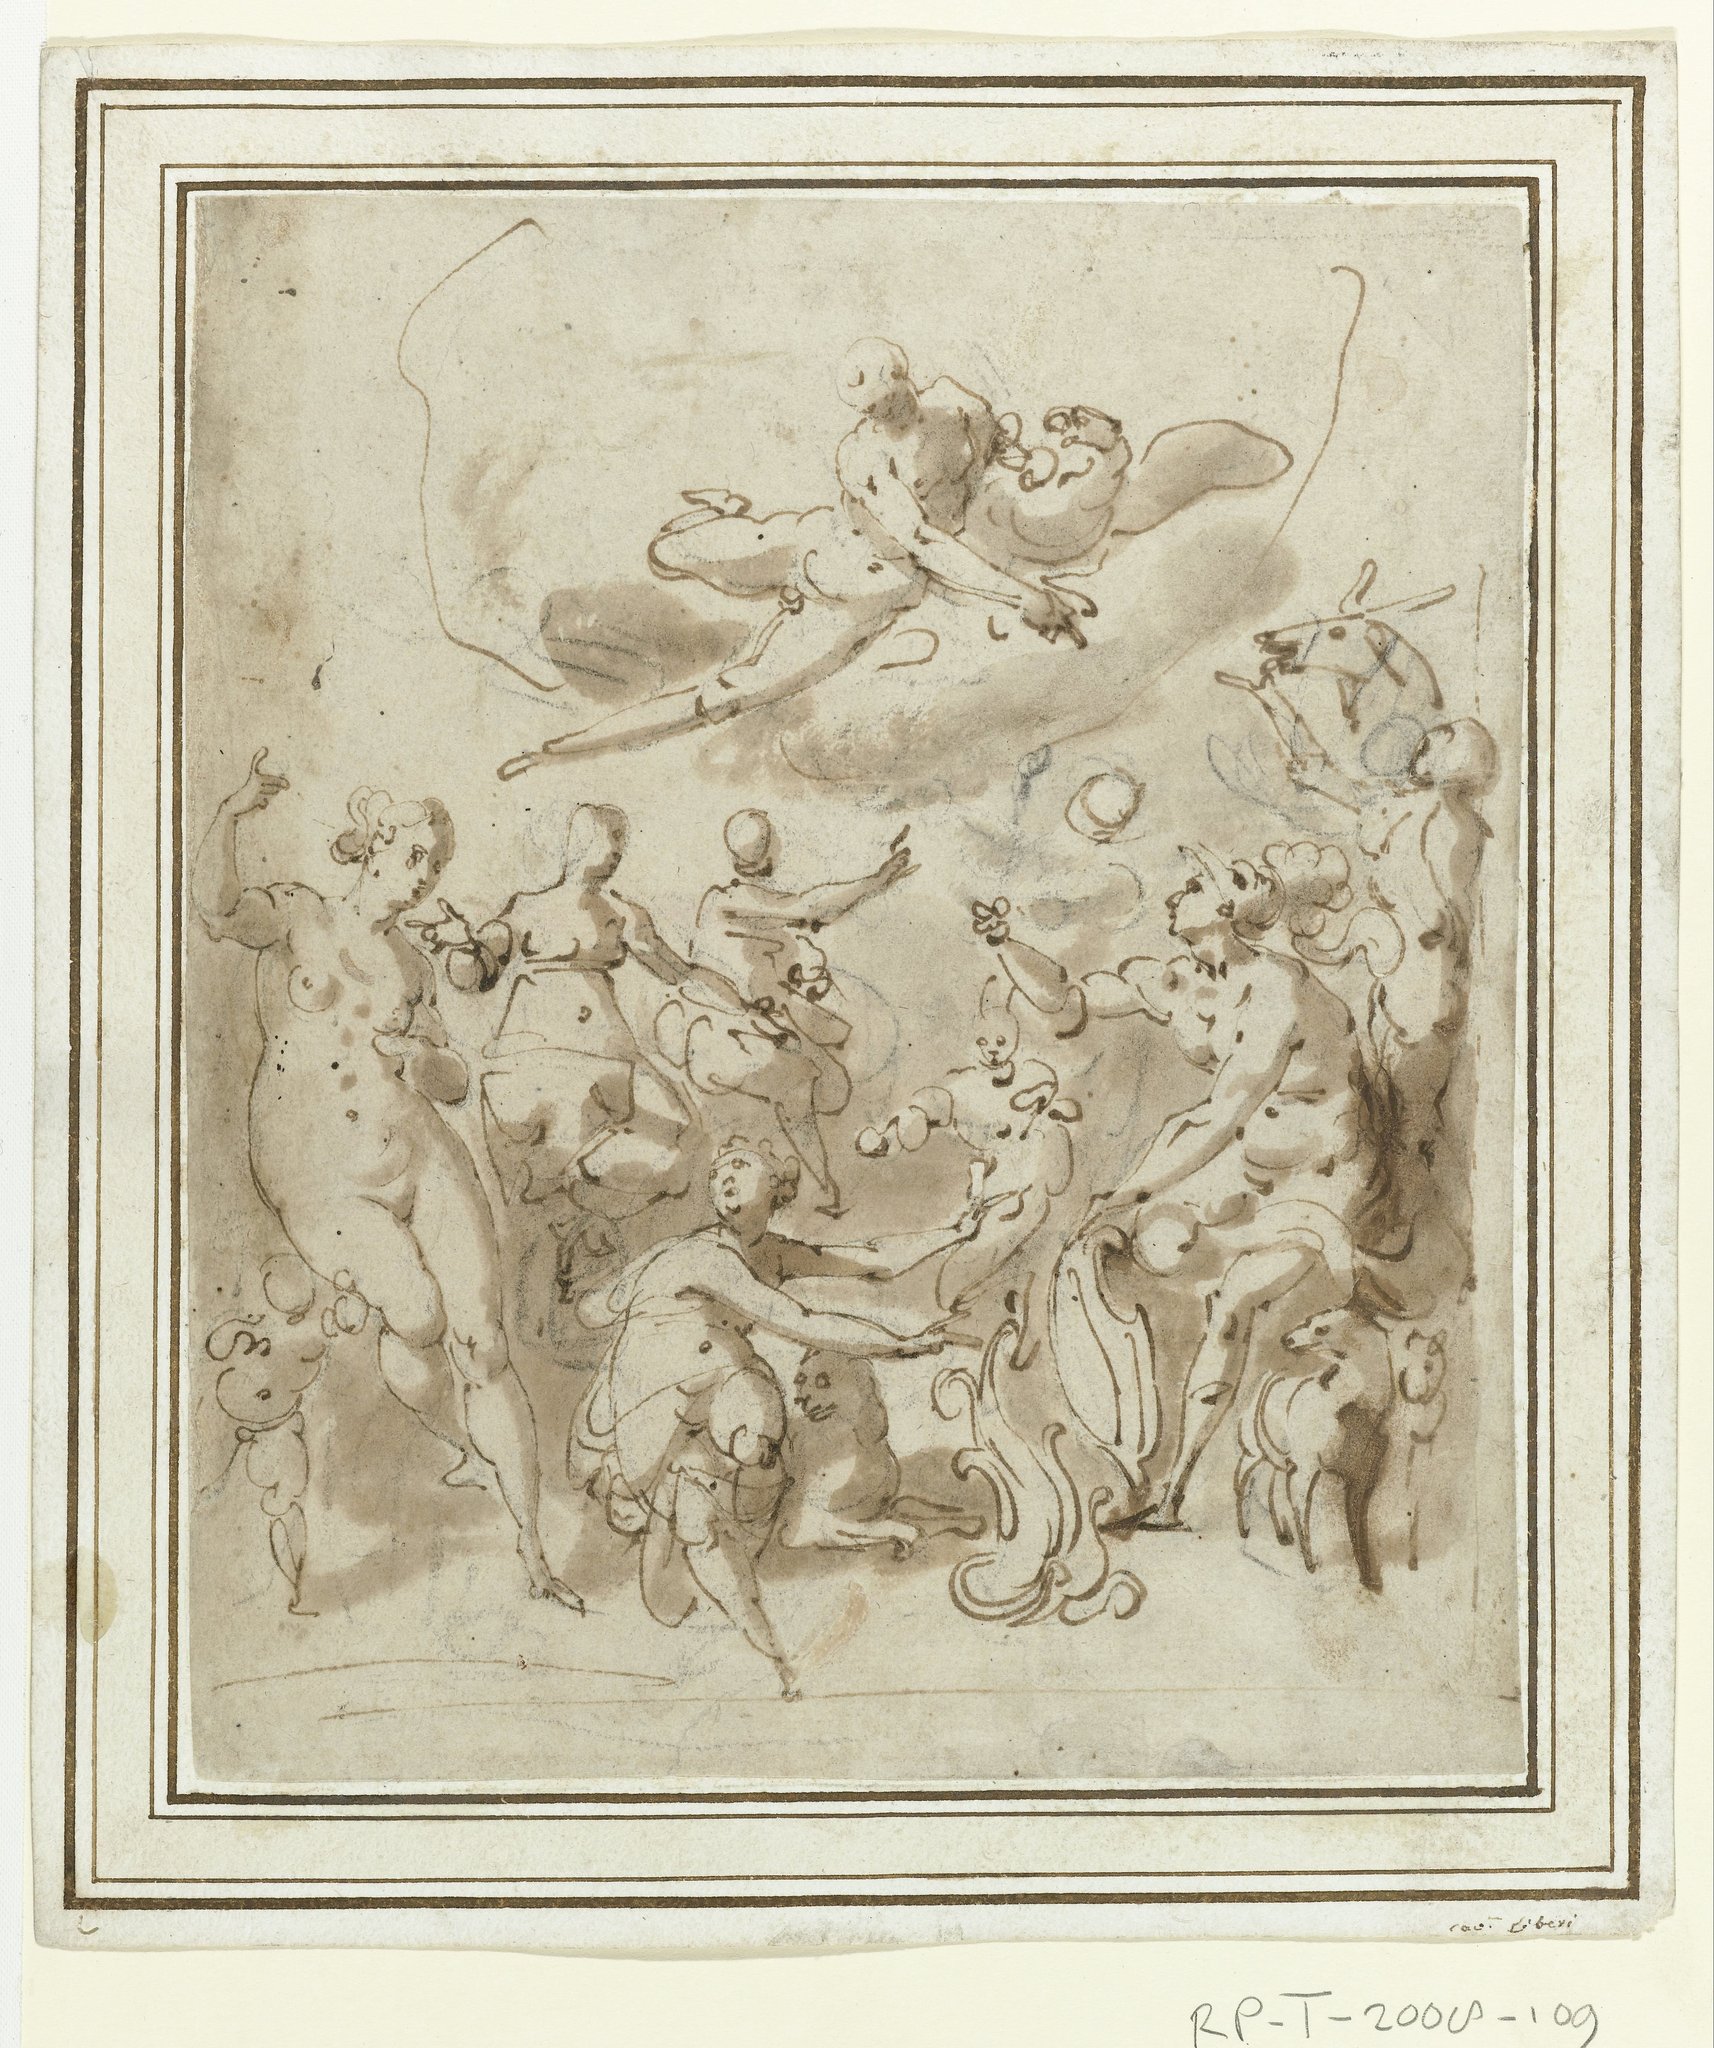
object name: drawing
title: Allegorie op de moed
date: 1567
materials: chalk, paper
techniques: brush, pen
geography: florence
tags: courage, bravery, valiance, manliness; 'ardire magnanimo et generoso', 'gagliardezza', 'valore', 'virtù heroica', 'virtù dell'animo e del corpo' (ripa)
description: This sketch is a study for a painting commissioned by Prince Francesco de’ Medici, from a series celebrating the family’s prosperous rule of Florence. The iconography is based on the Judgement of Paris, with an additional political subtext alluding to the choices a sovereign has to make. The elegant dancing figures, and complex allegorical content, are typical qualities of Florentine Mannerist art.